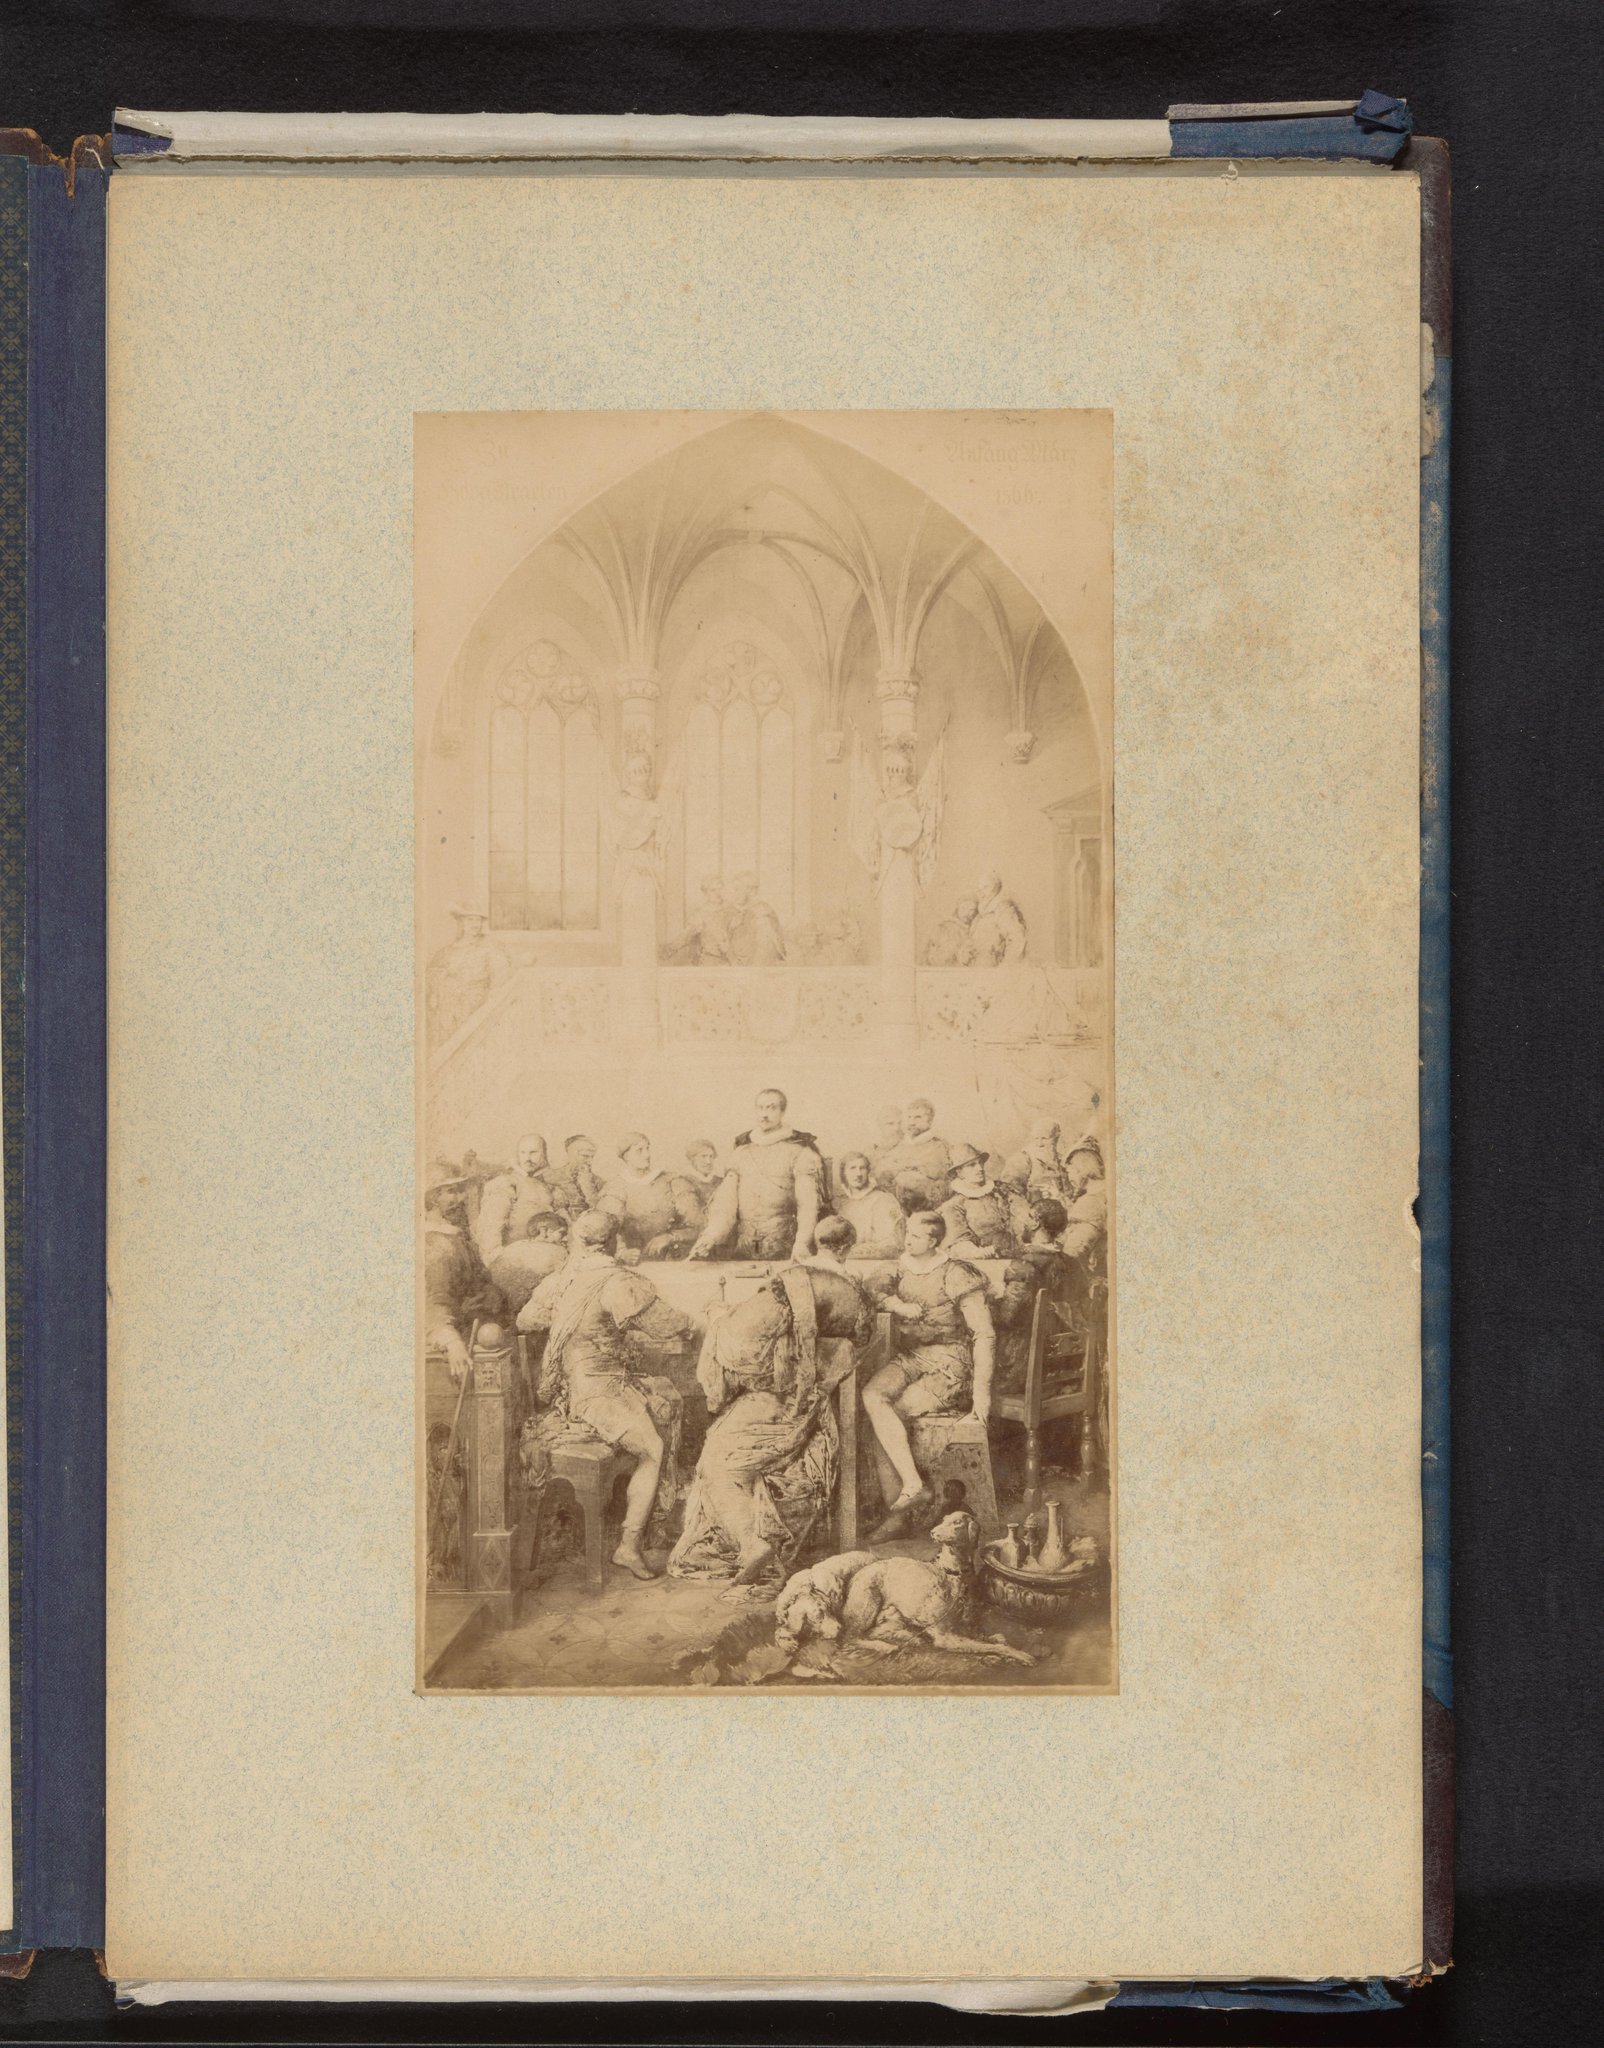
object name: reproduction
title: Fotoreproductie van Tracht het Verzoekschrift der Edelen te matigen door Laurens Lodewijk Kleijn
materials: photographic support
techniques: albumen print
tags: delft, william i (prince of orange), meeting, assembly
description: Deze foto maakt deel uit van een omslag met acht foto's op acht bladen en twee tekstbladen.